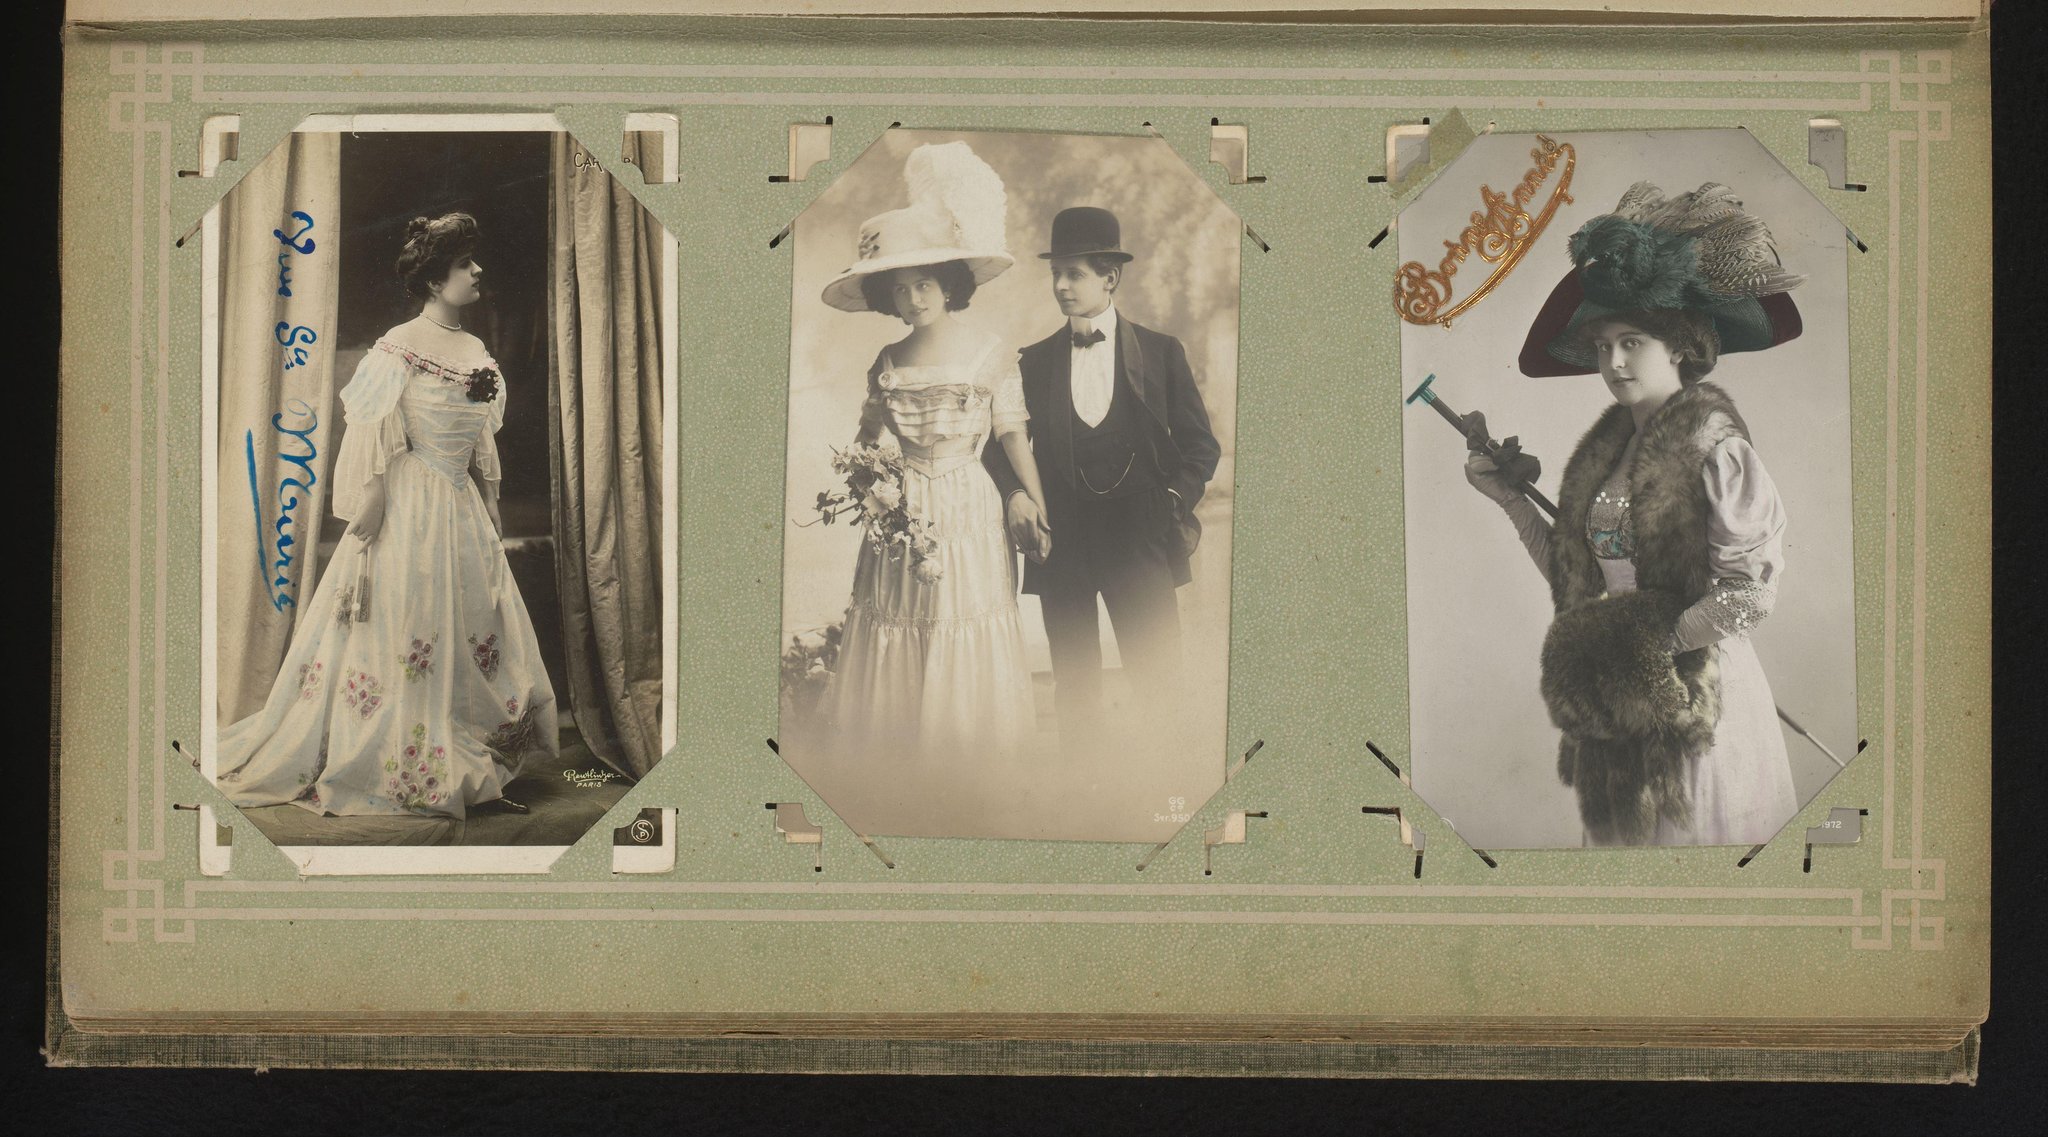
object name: album leaf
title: Twee portretten van vrouwen en een portret van een echtpaar in bruidskleding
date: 1900-1930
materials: cardboard, ink, photographic support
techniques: gelatin silver print, hand coloring, pen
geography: paris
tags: historical persons - bb - woman, bride and groom in wedding-dress, marriage, married couple, 'matrimonium', head-gear: hat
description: Deze foto's maken deel uit van een album.